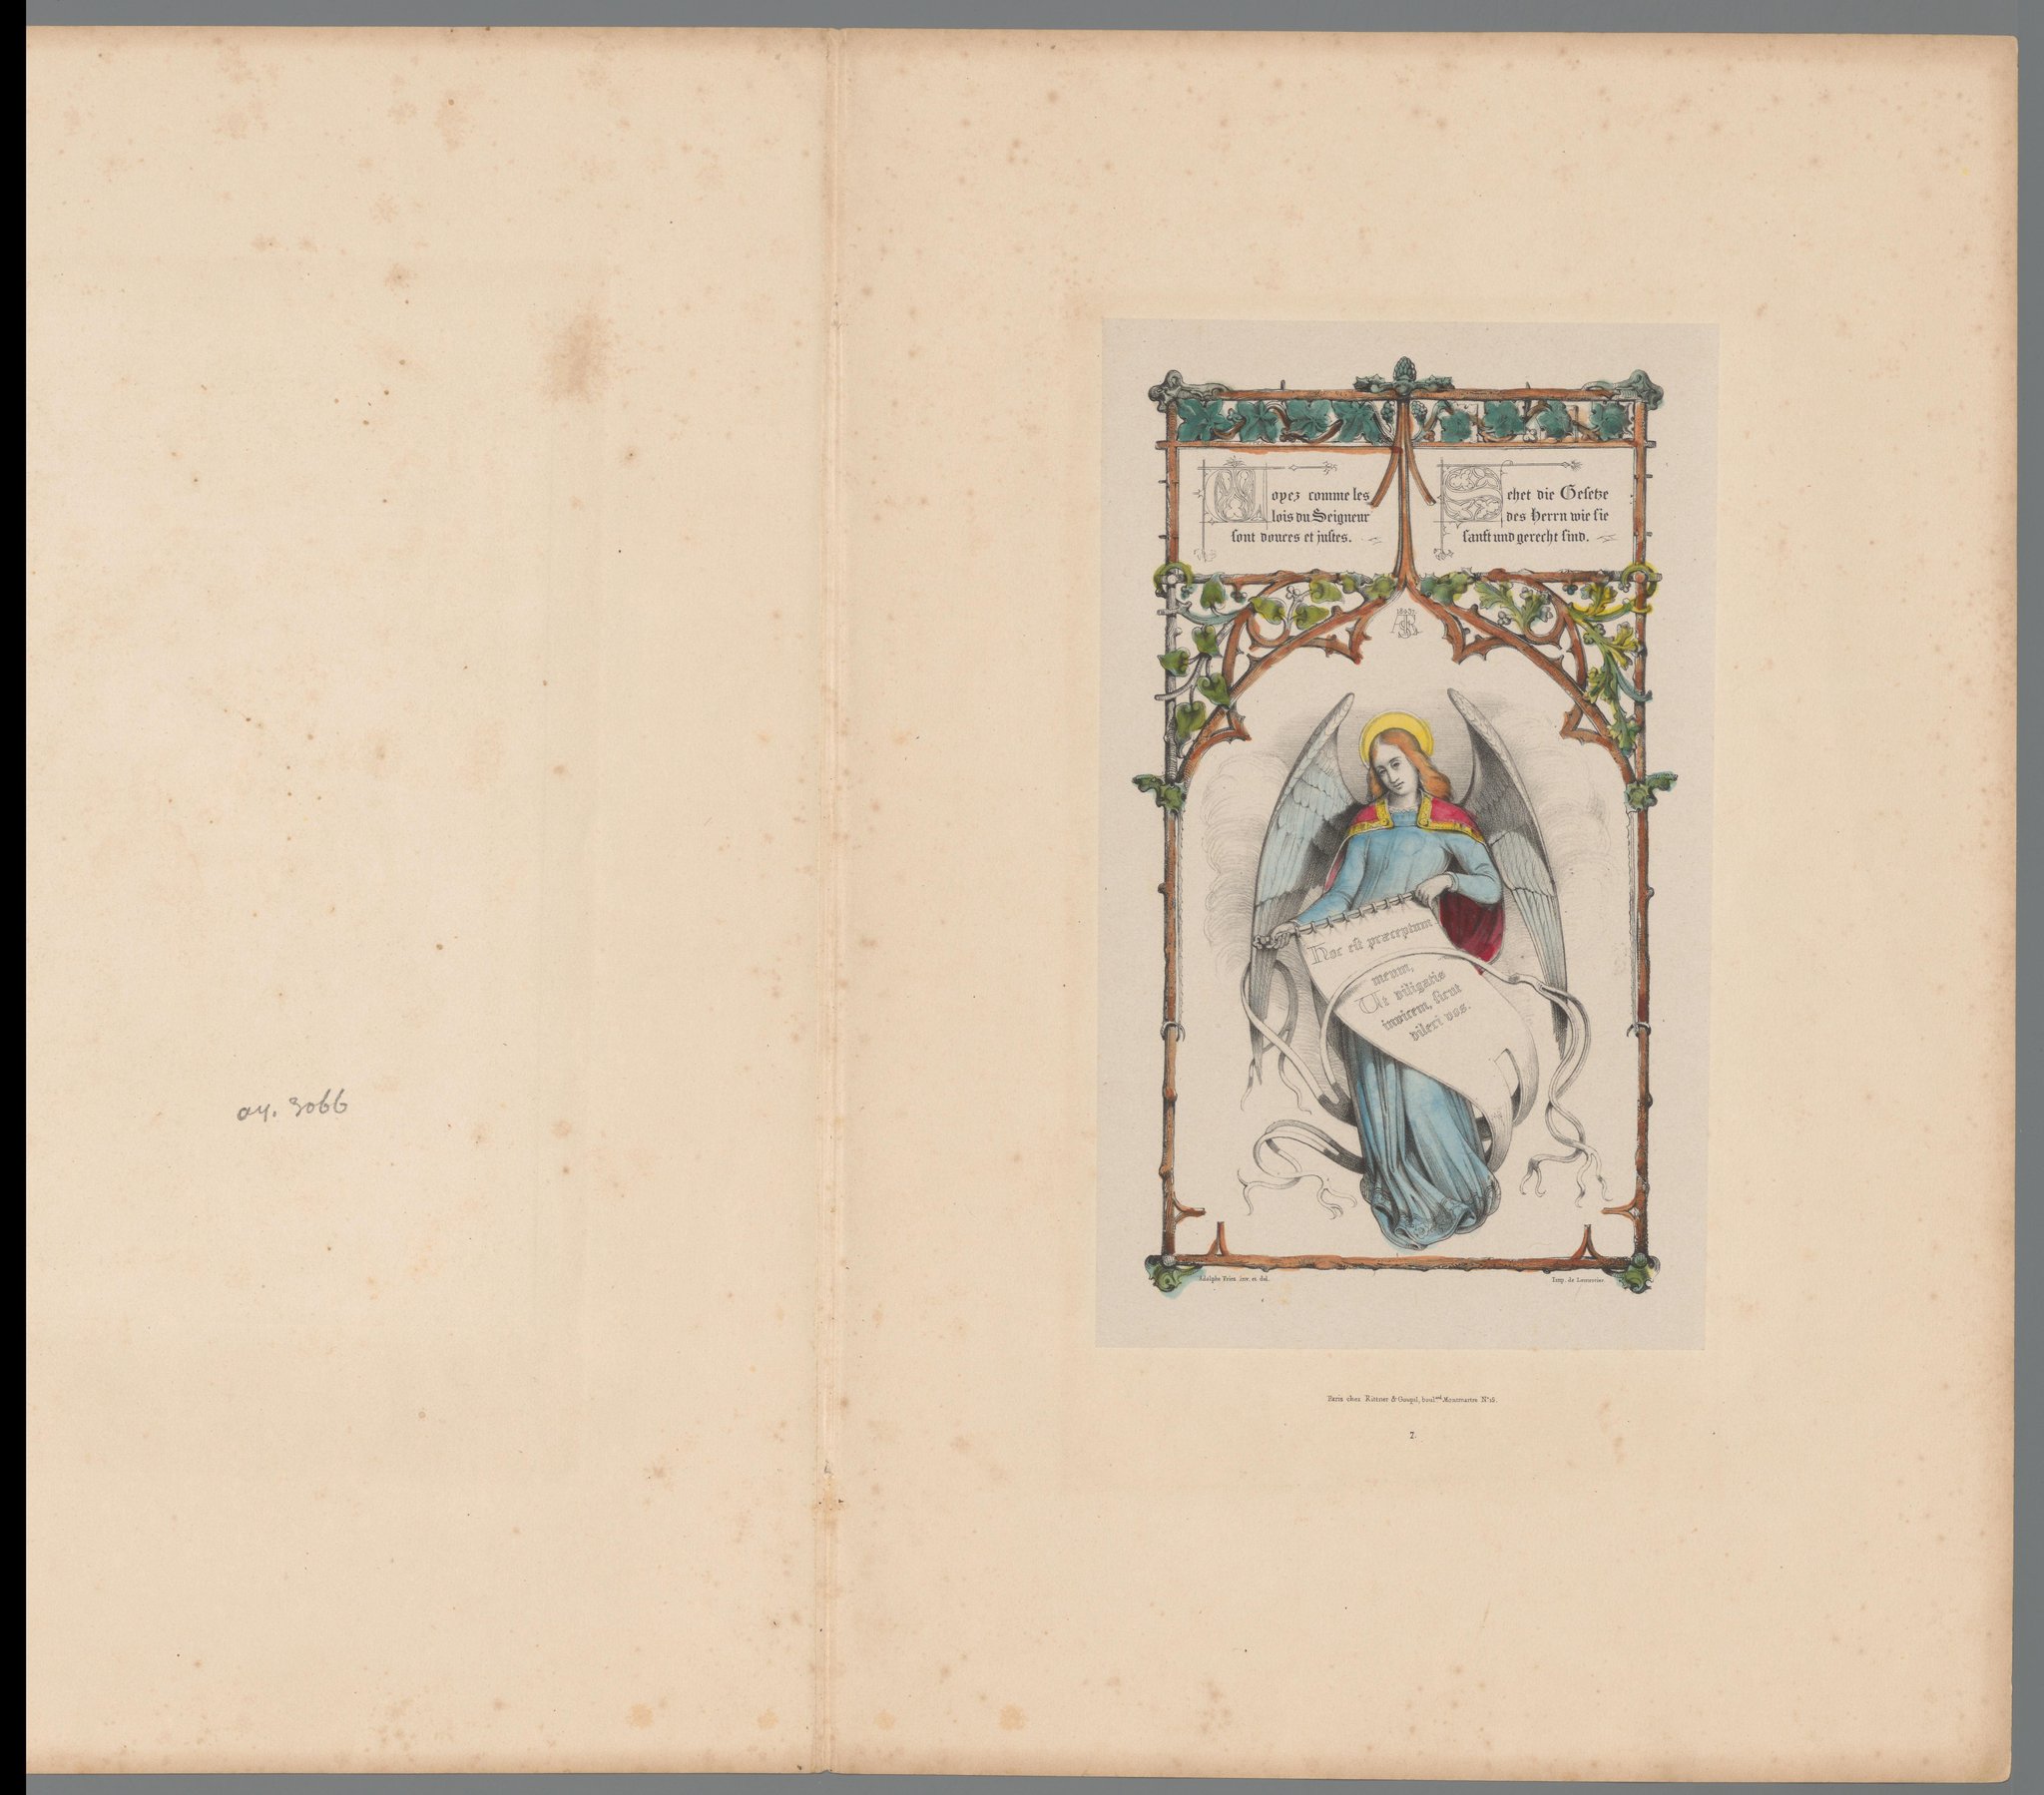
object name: print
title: Engel met vaandel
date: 1837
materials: paper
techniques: hand coloring, lithograph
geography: paris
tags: angel(s) with book(-scroll) or banderole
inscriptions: collector's mark: Lugt 2228